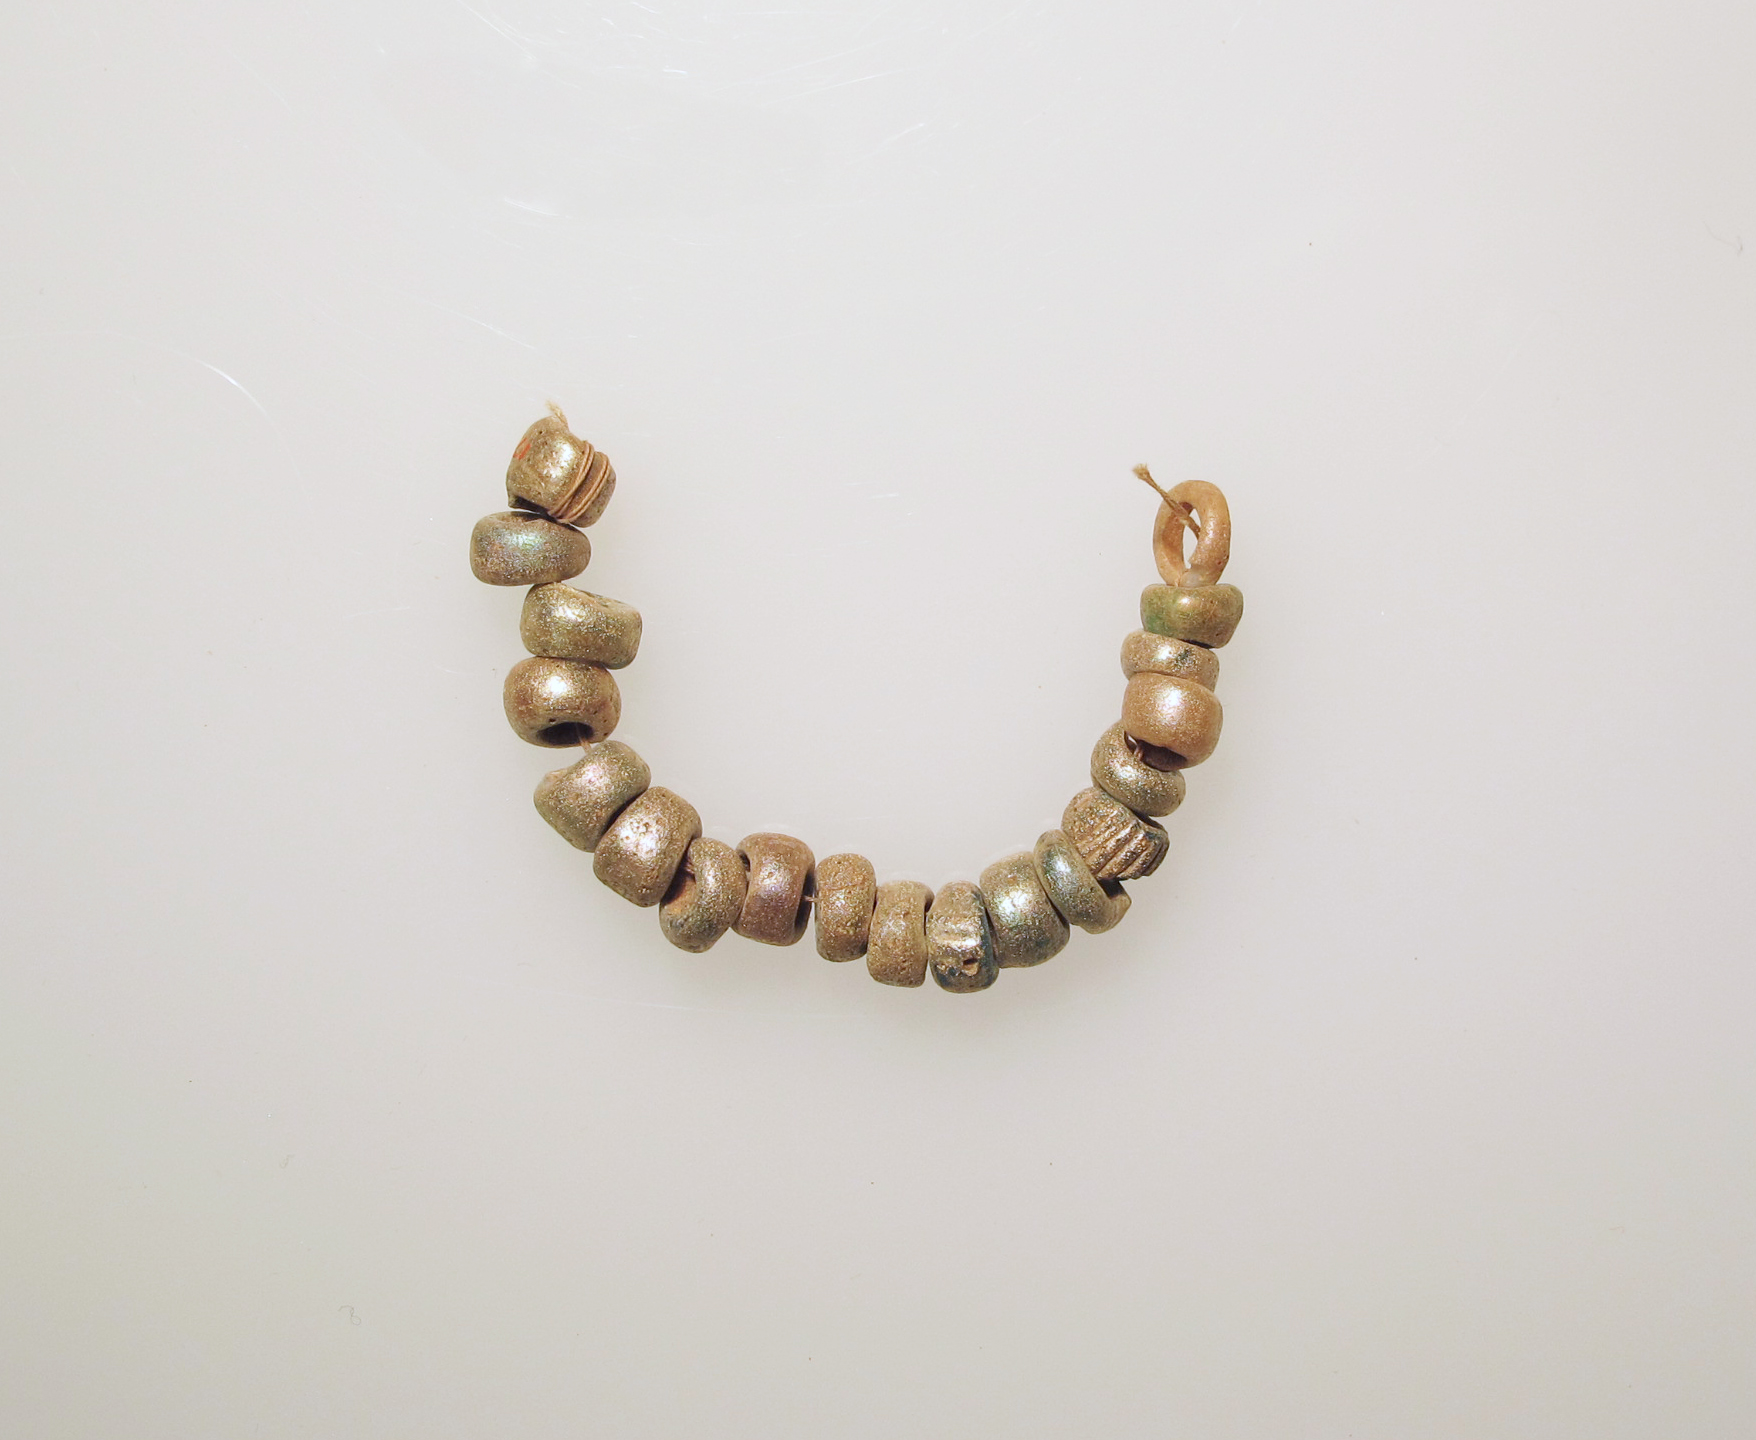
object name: bead, 19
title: Beads, 19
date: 7000 BCE-330 CE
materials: glass